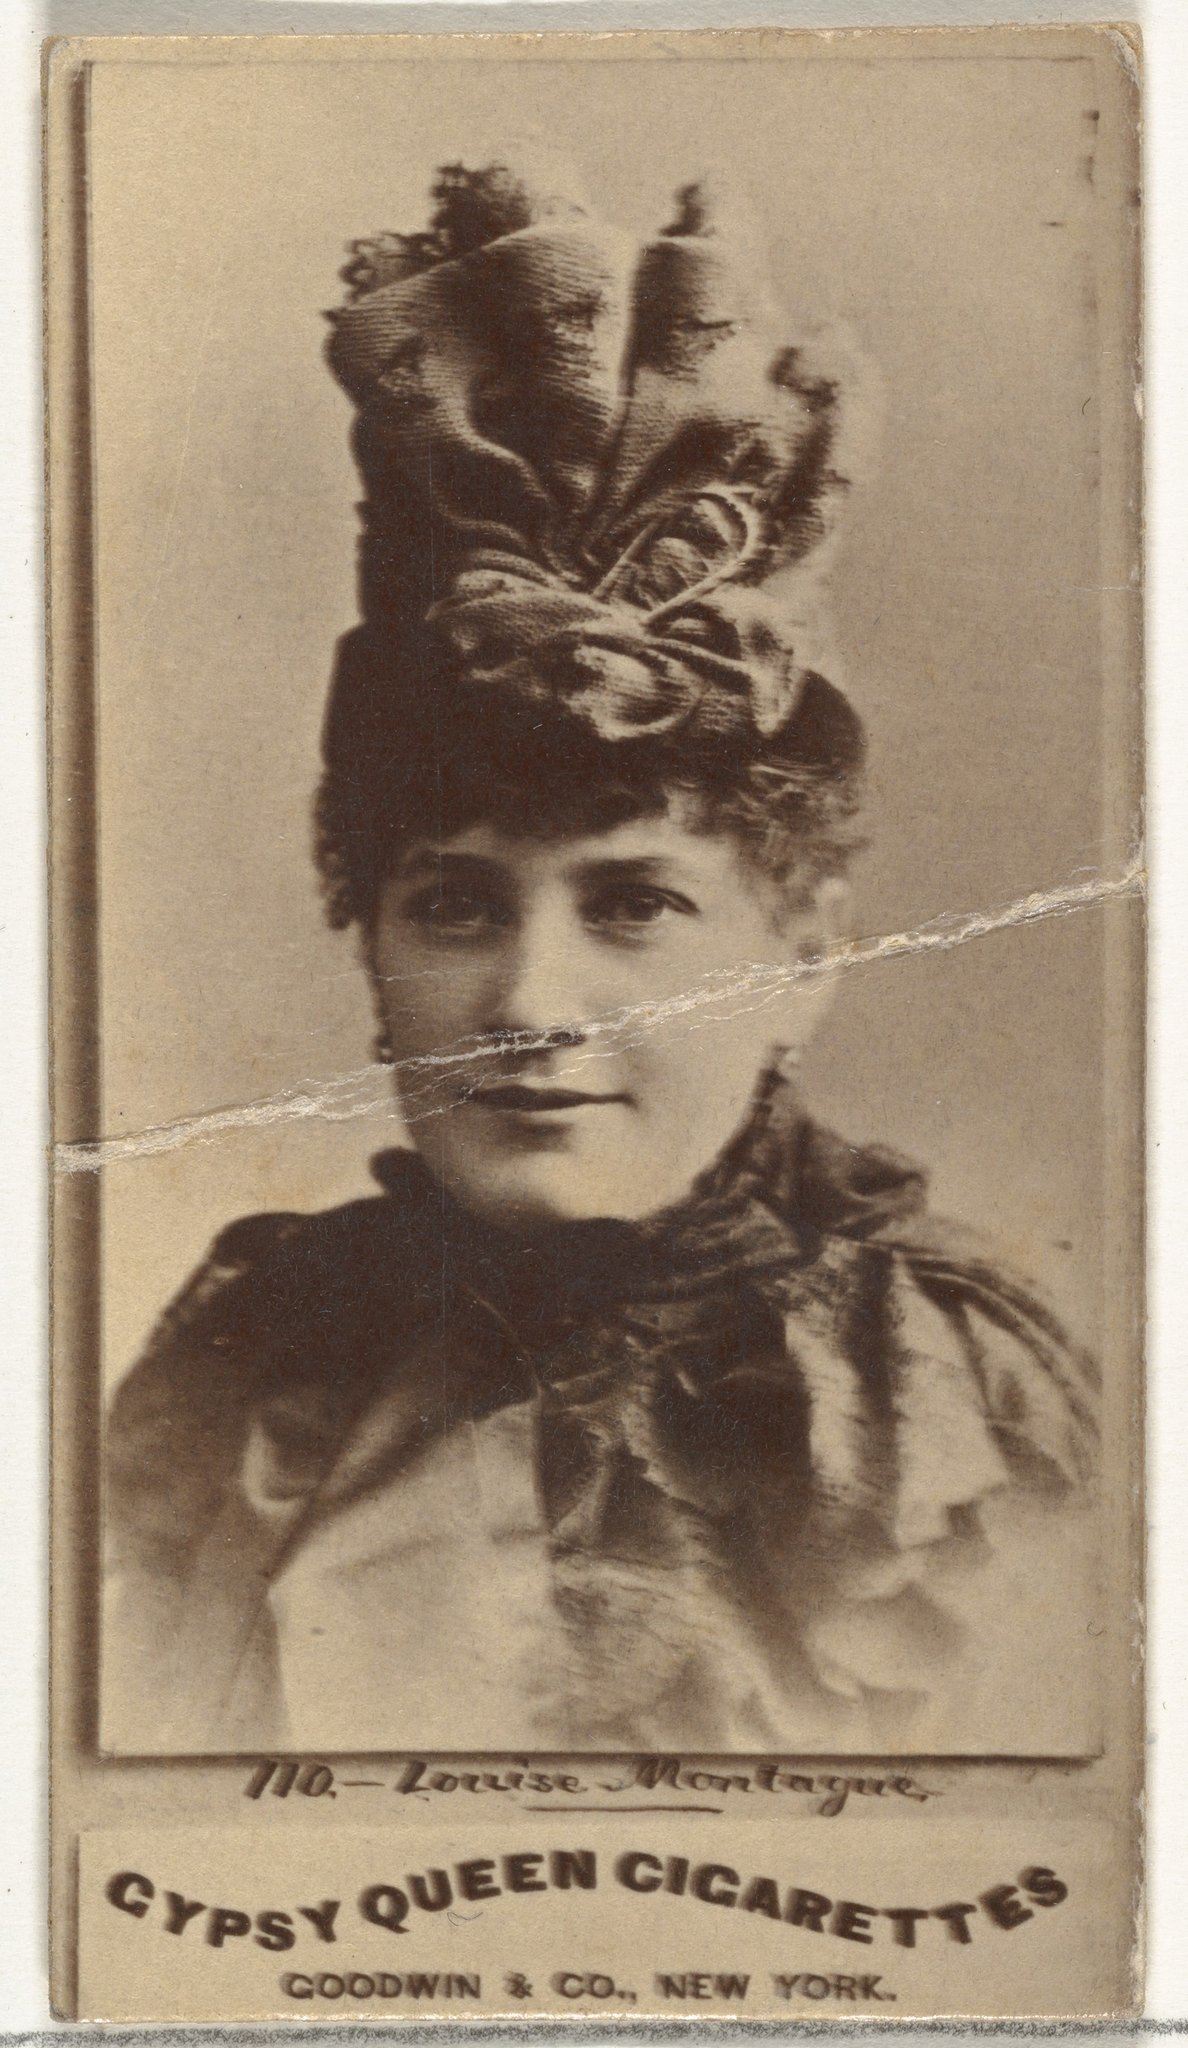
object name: photograph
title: Louise Montague, from the Actors and Actresses series (N171) for Gypsy Queen Cigarettes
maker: goodwin & company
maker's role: publisher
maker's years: 1850-1950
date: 1886-1890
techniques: albumen silver print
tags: portraits,women,actresses